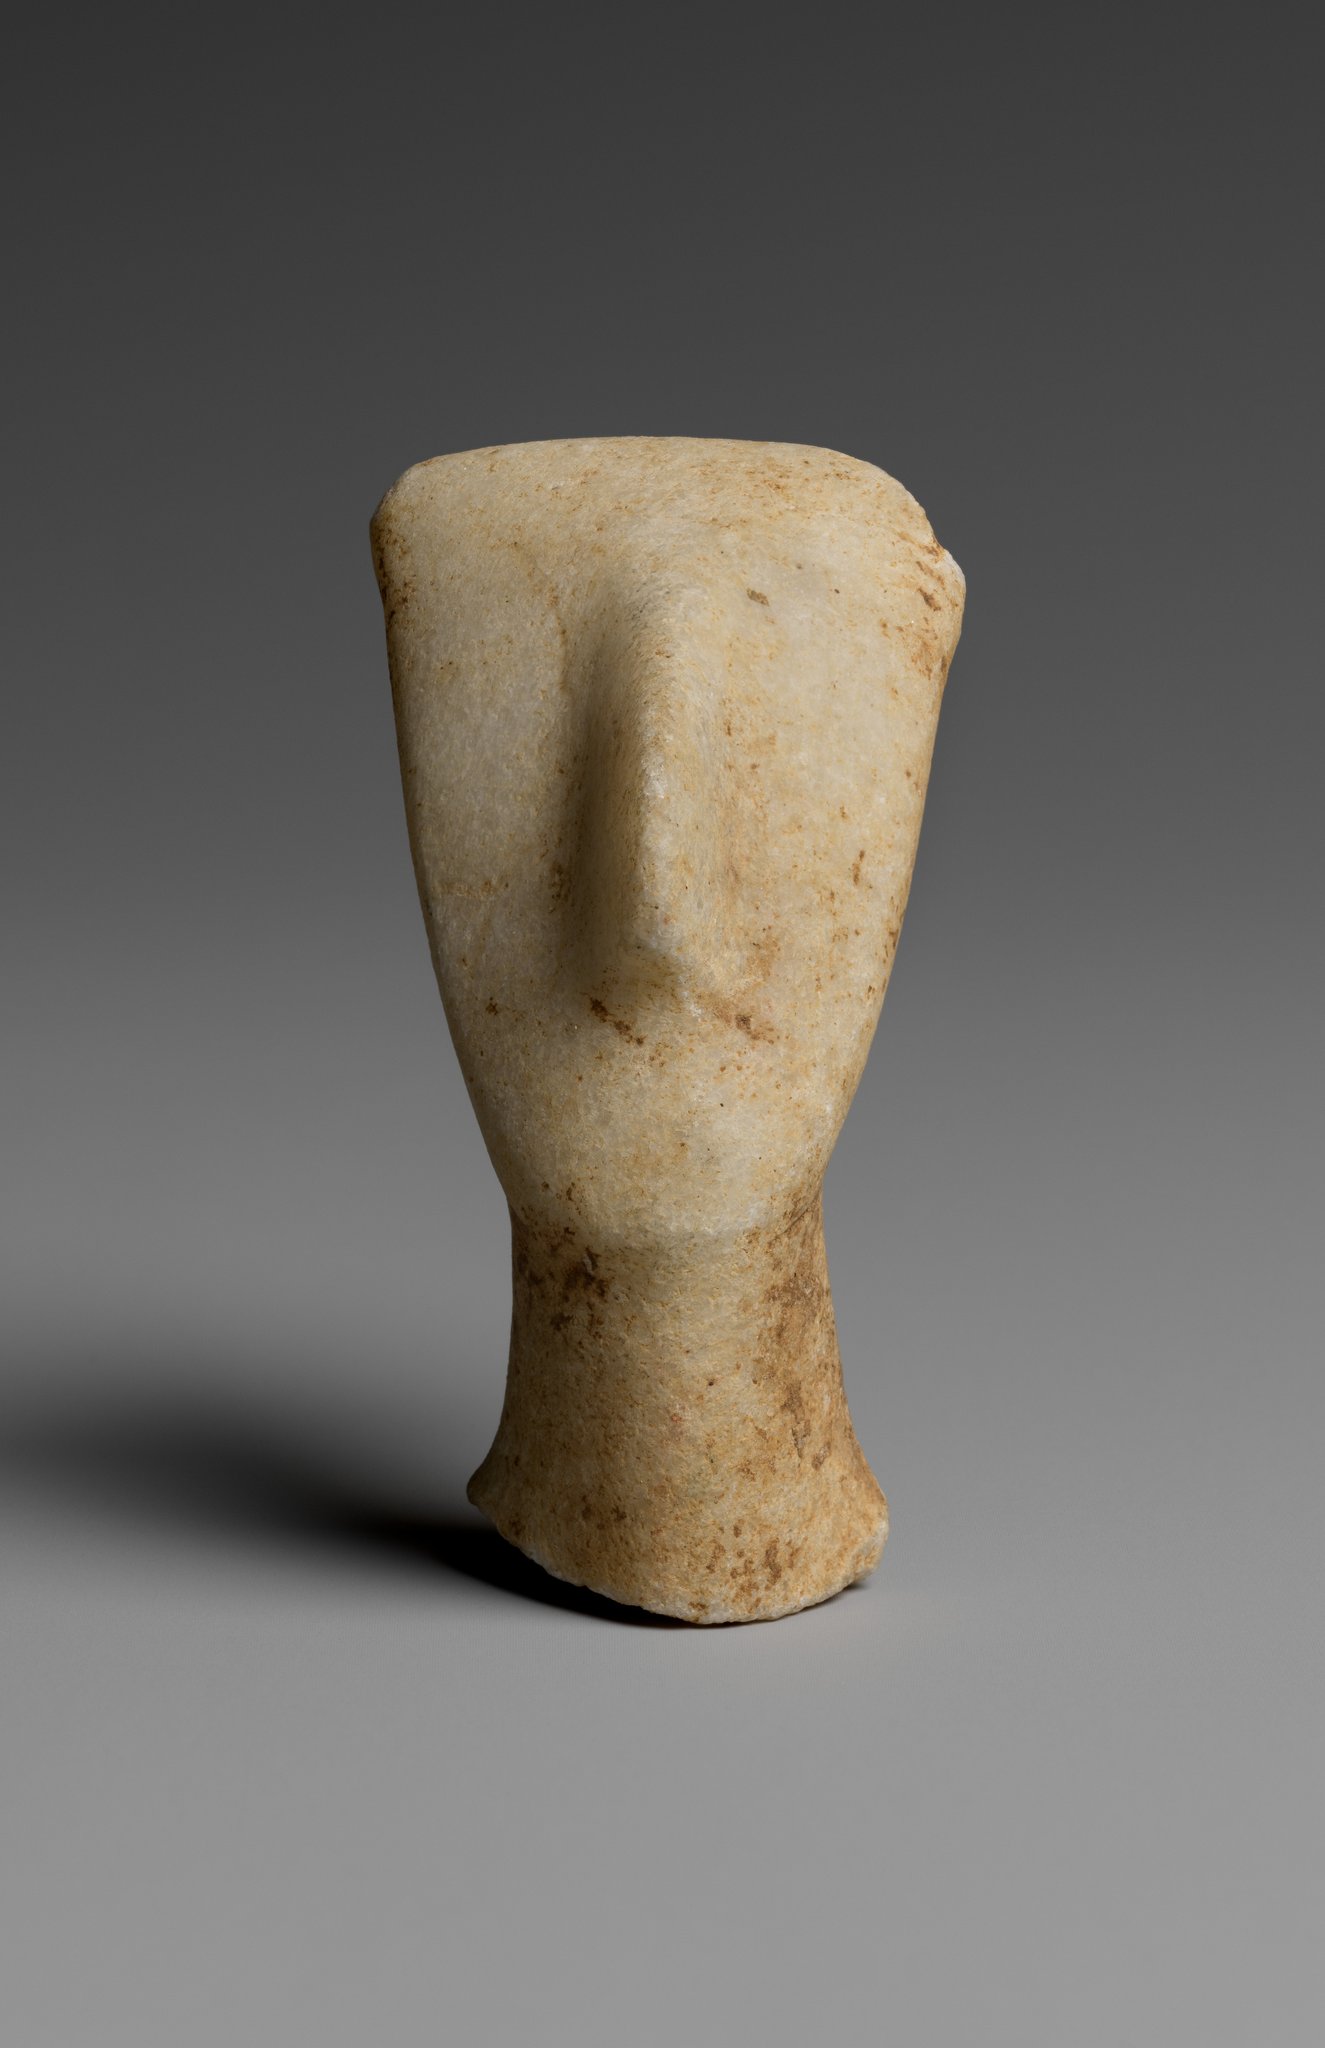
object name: head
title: Head and neck from a marble figure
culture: cycladic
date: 2700-2300 BCE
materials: marble